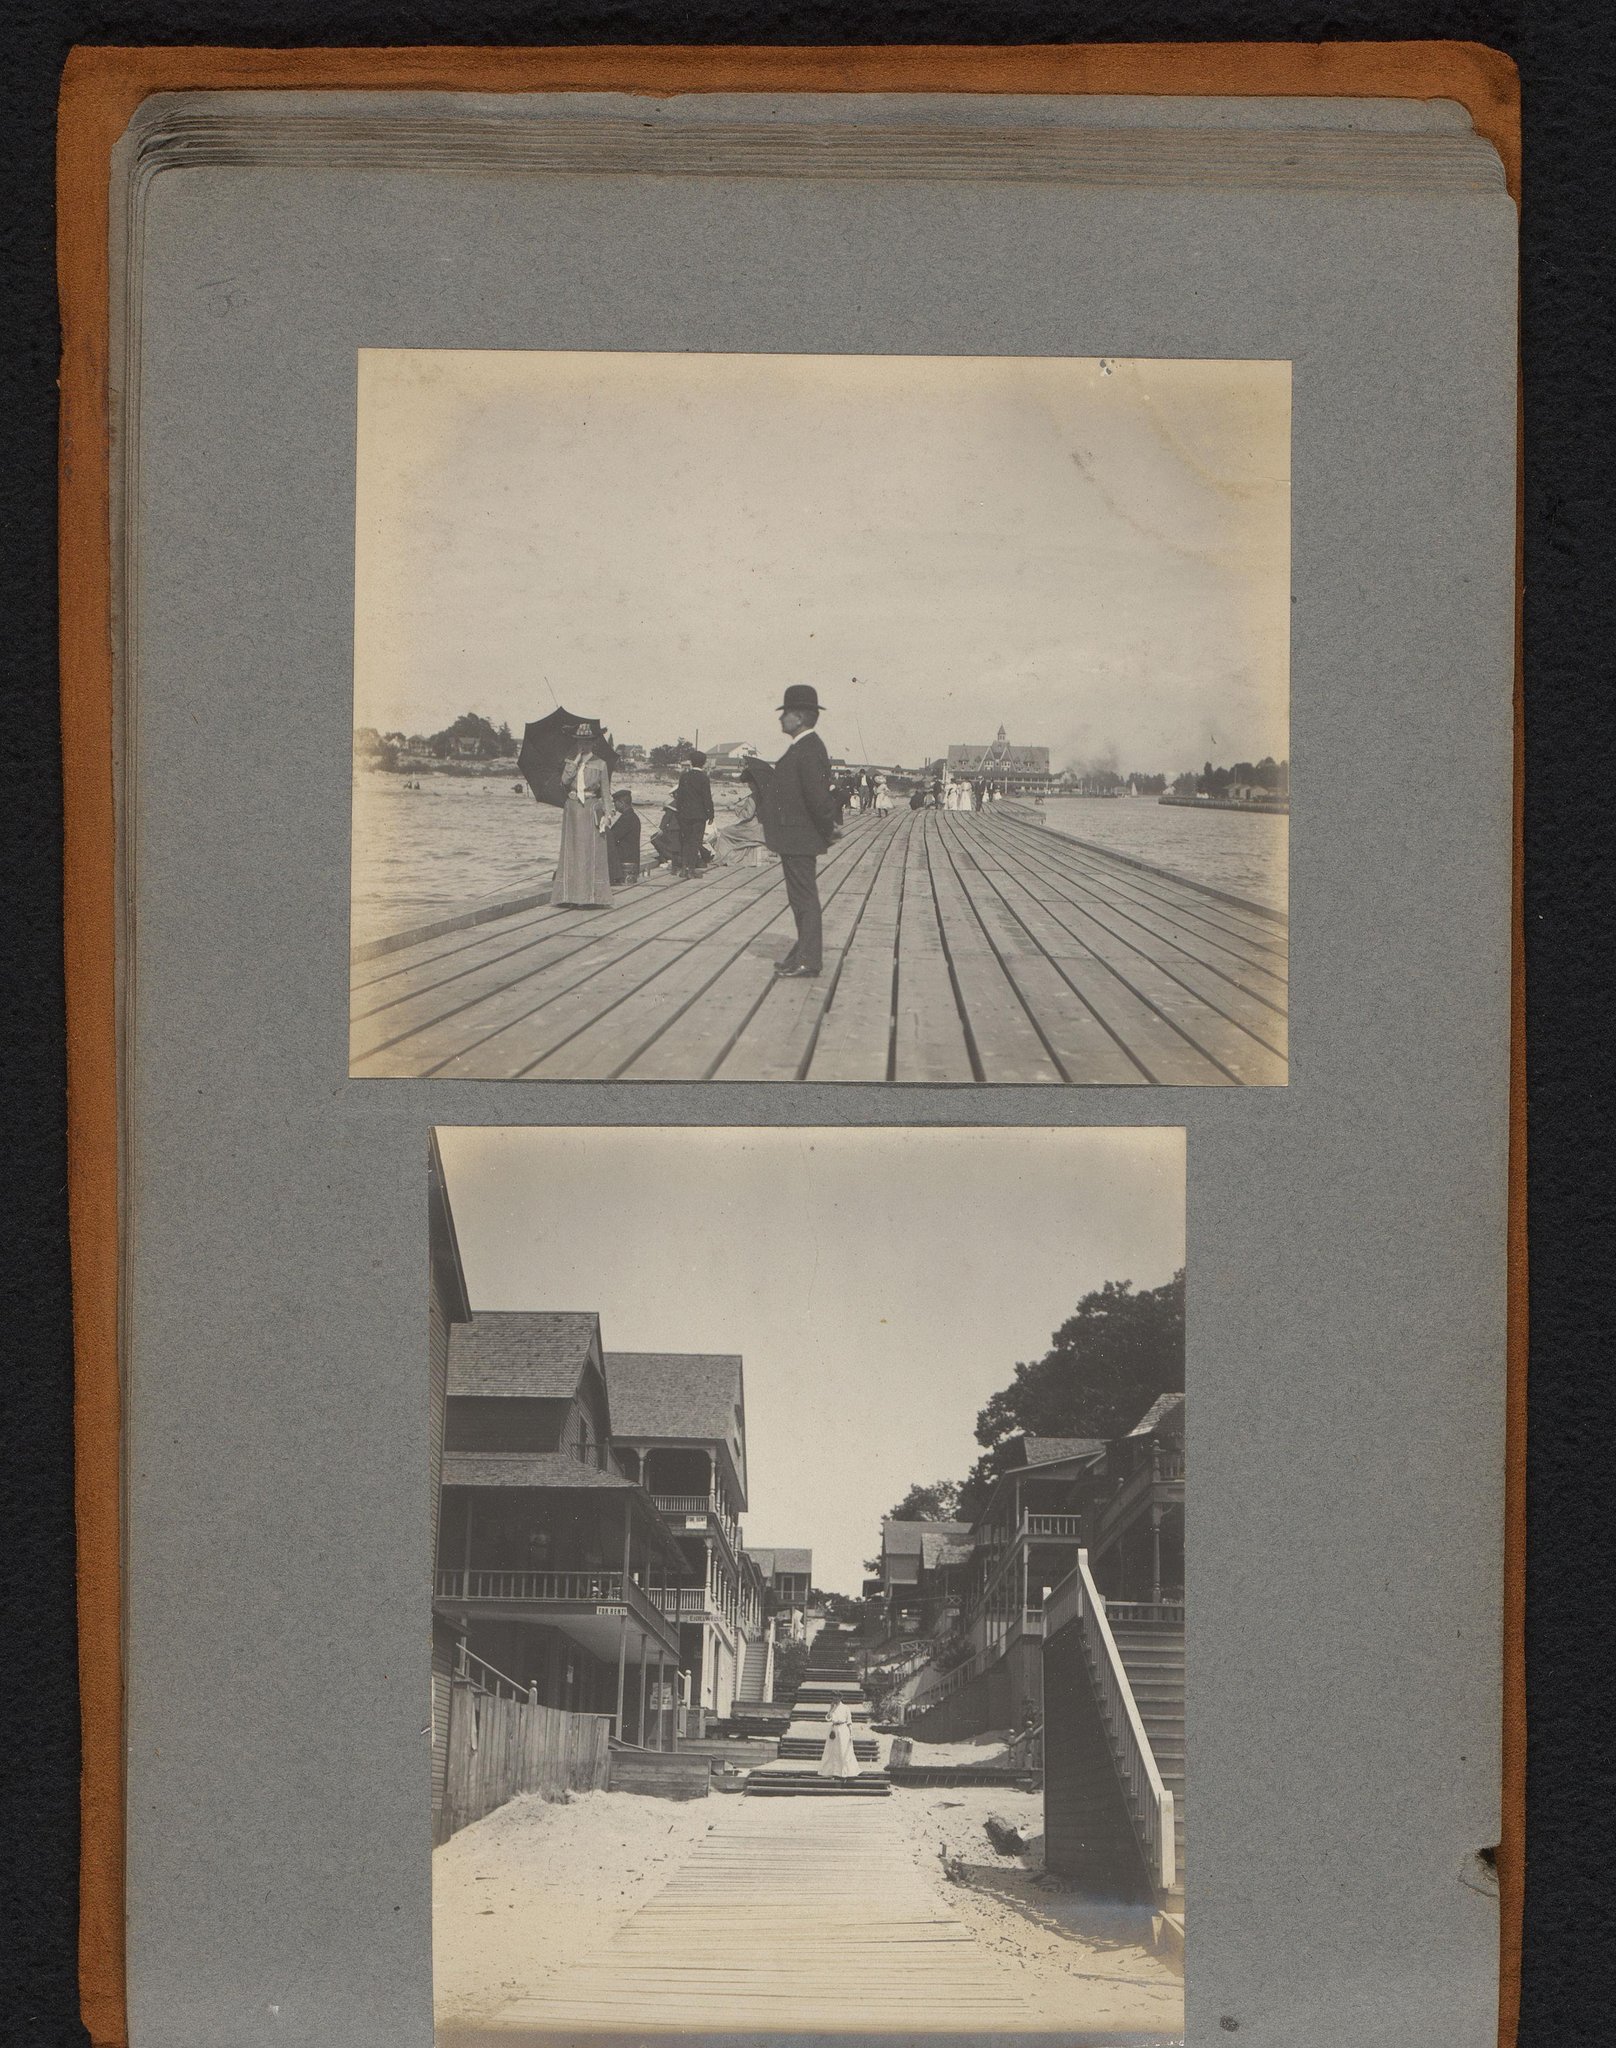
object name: photograph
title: Vissende en wandelende mensen op een pier en een houten pad tussen strandhuizen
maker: jan van der mey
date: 1902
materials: paper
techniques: gelatin silver print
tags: cottage, pier, quay, wharf, beach, historical persons not known by name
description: Deze foto's maken deel uit van een album.